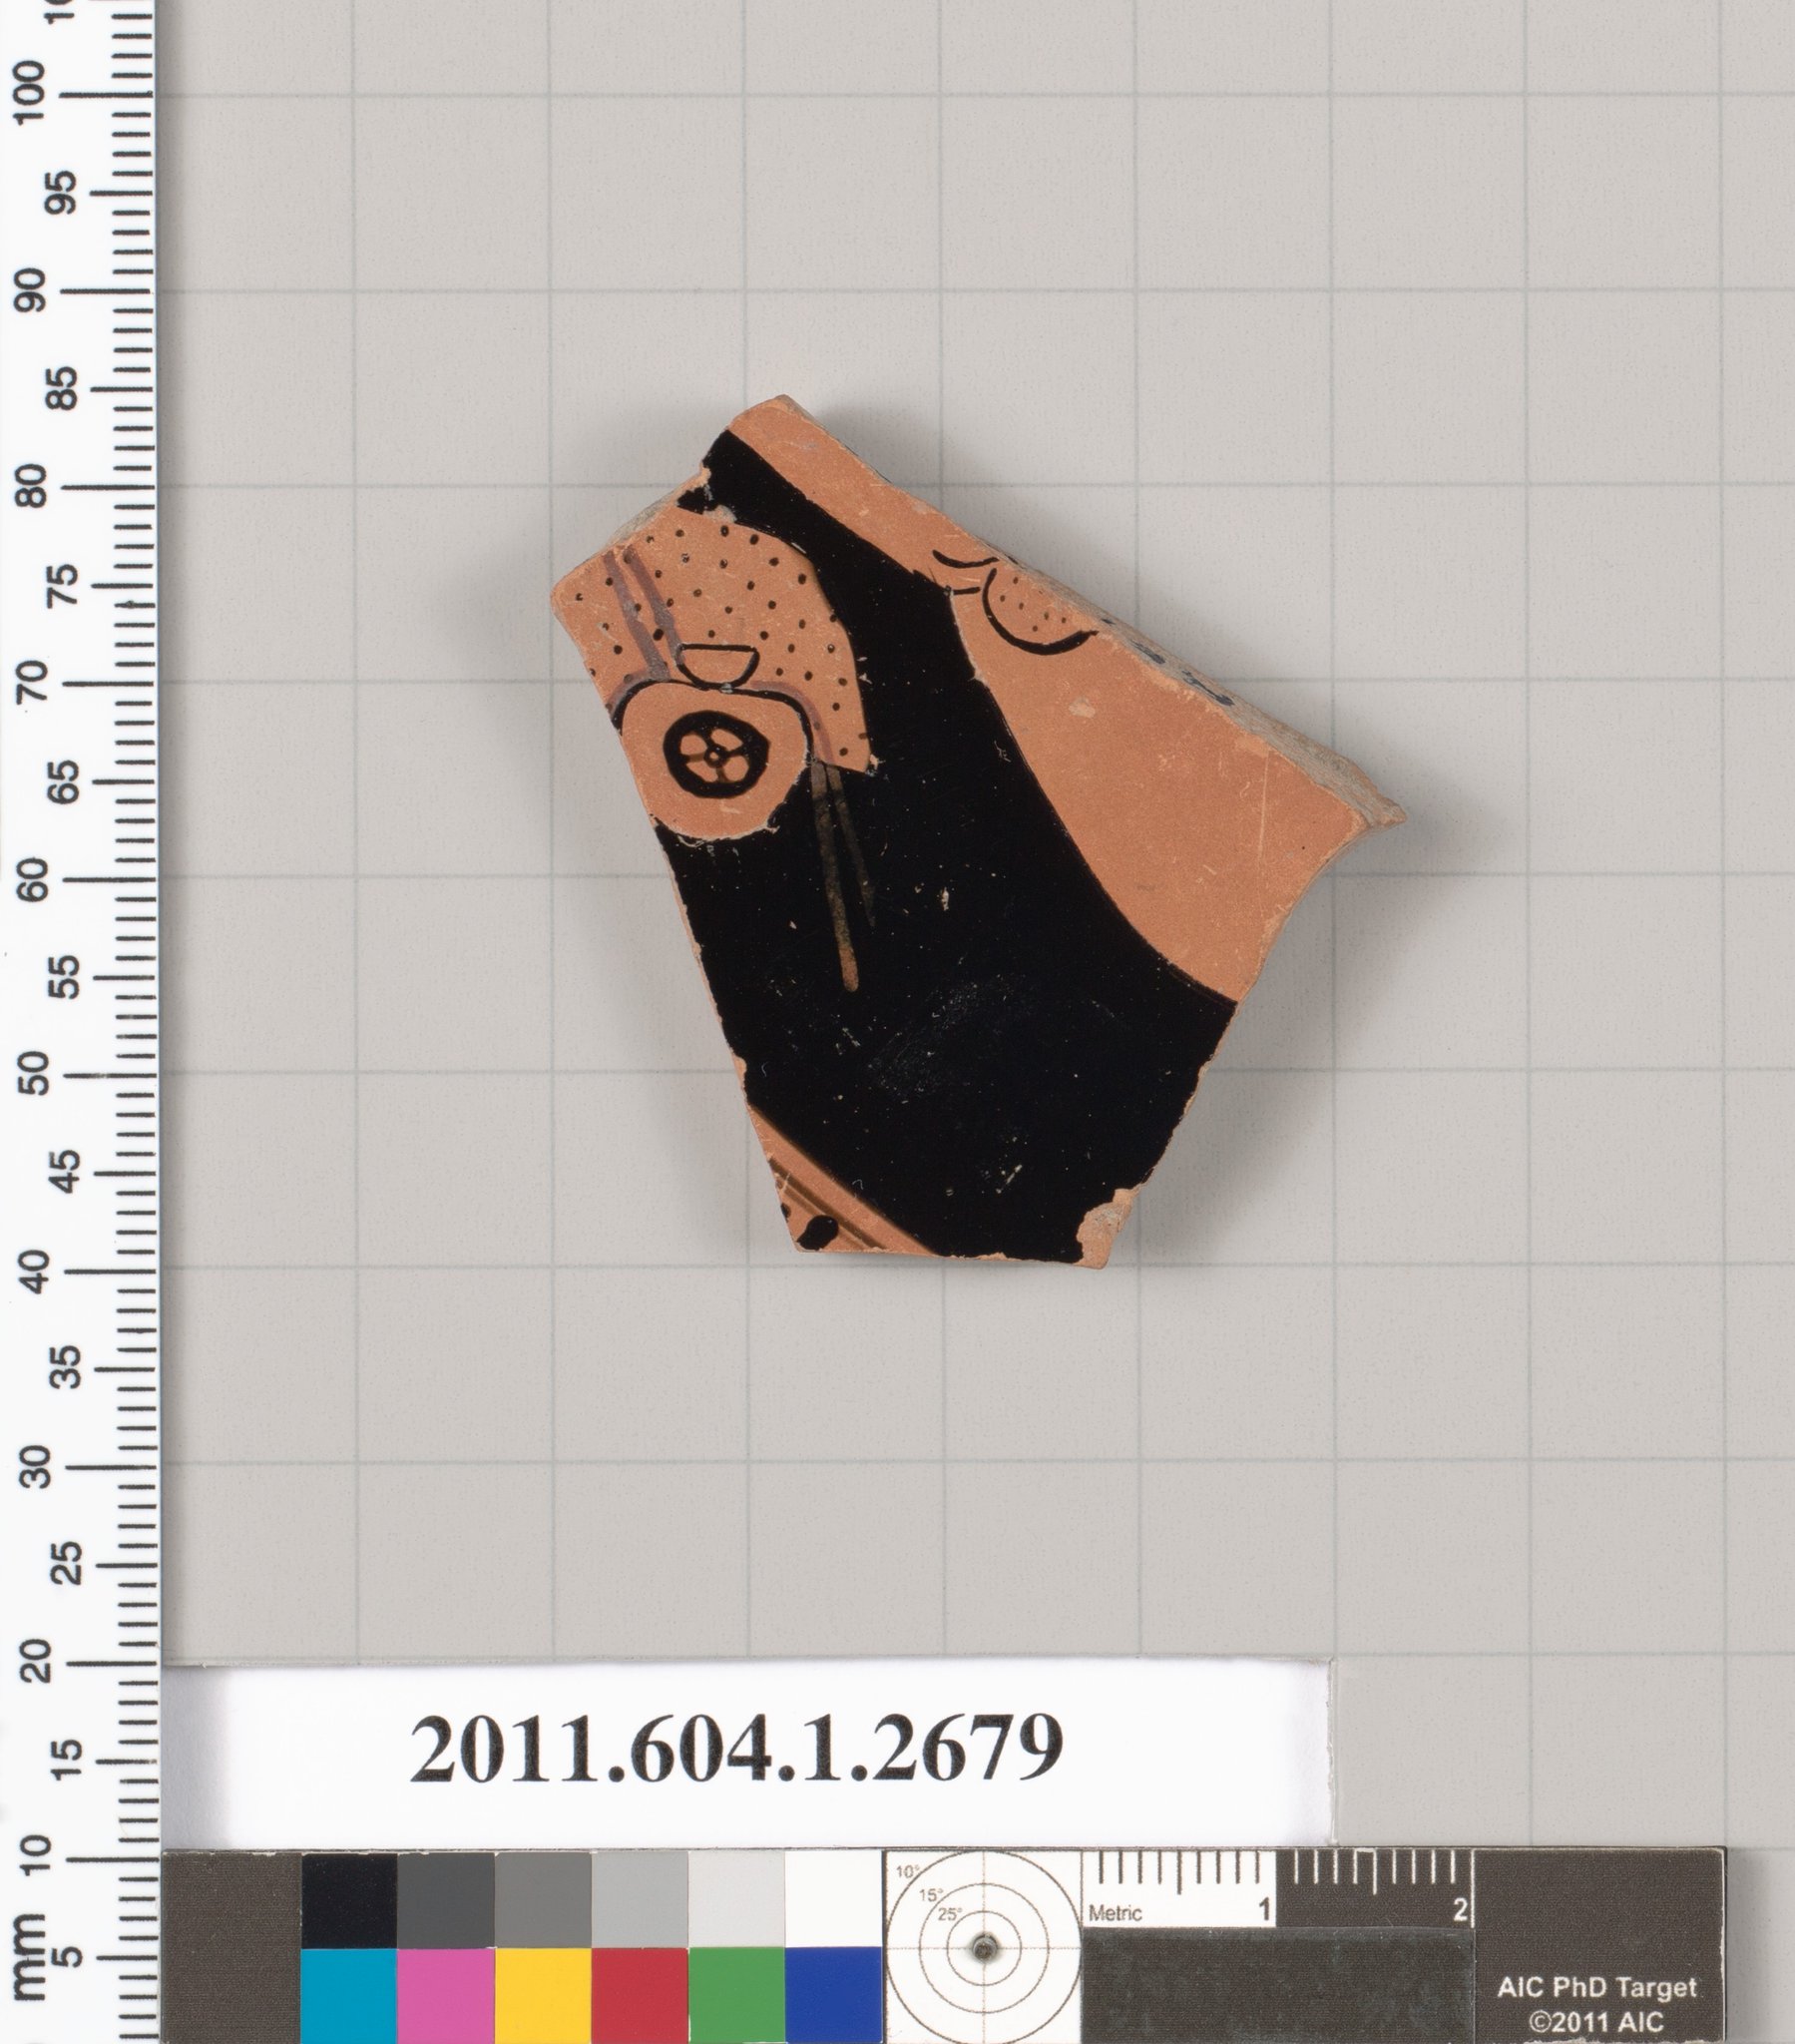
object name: kylix fragment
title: Terracotta fragment of a kylix (drinking cup)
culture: greek, attic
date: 500-490 BCE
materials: terracotta